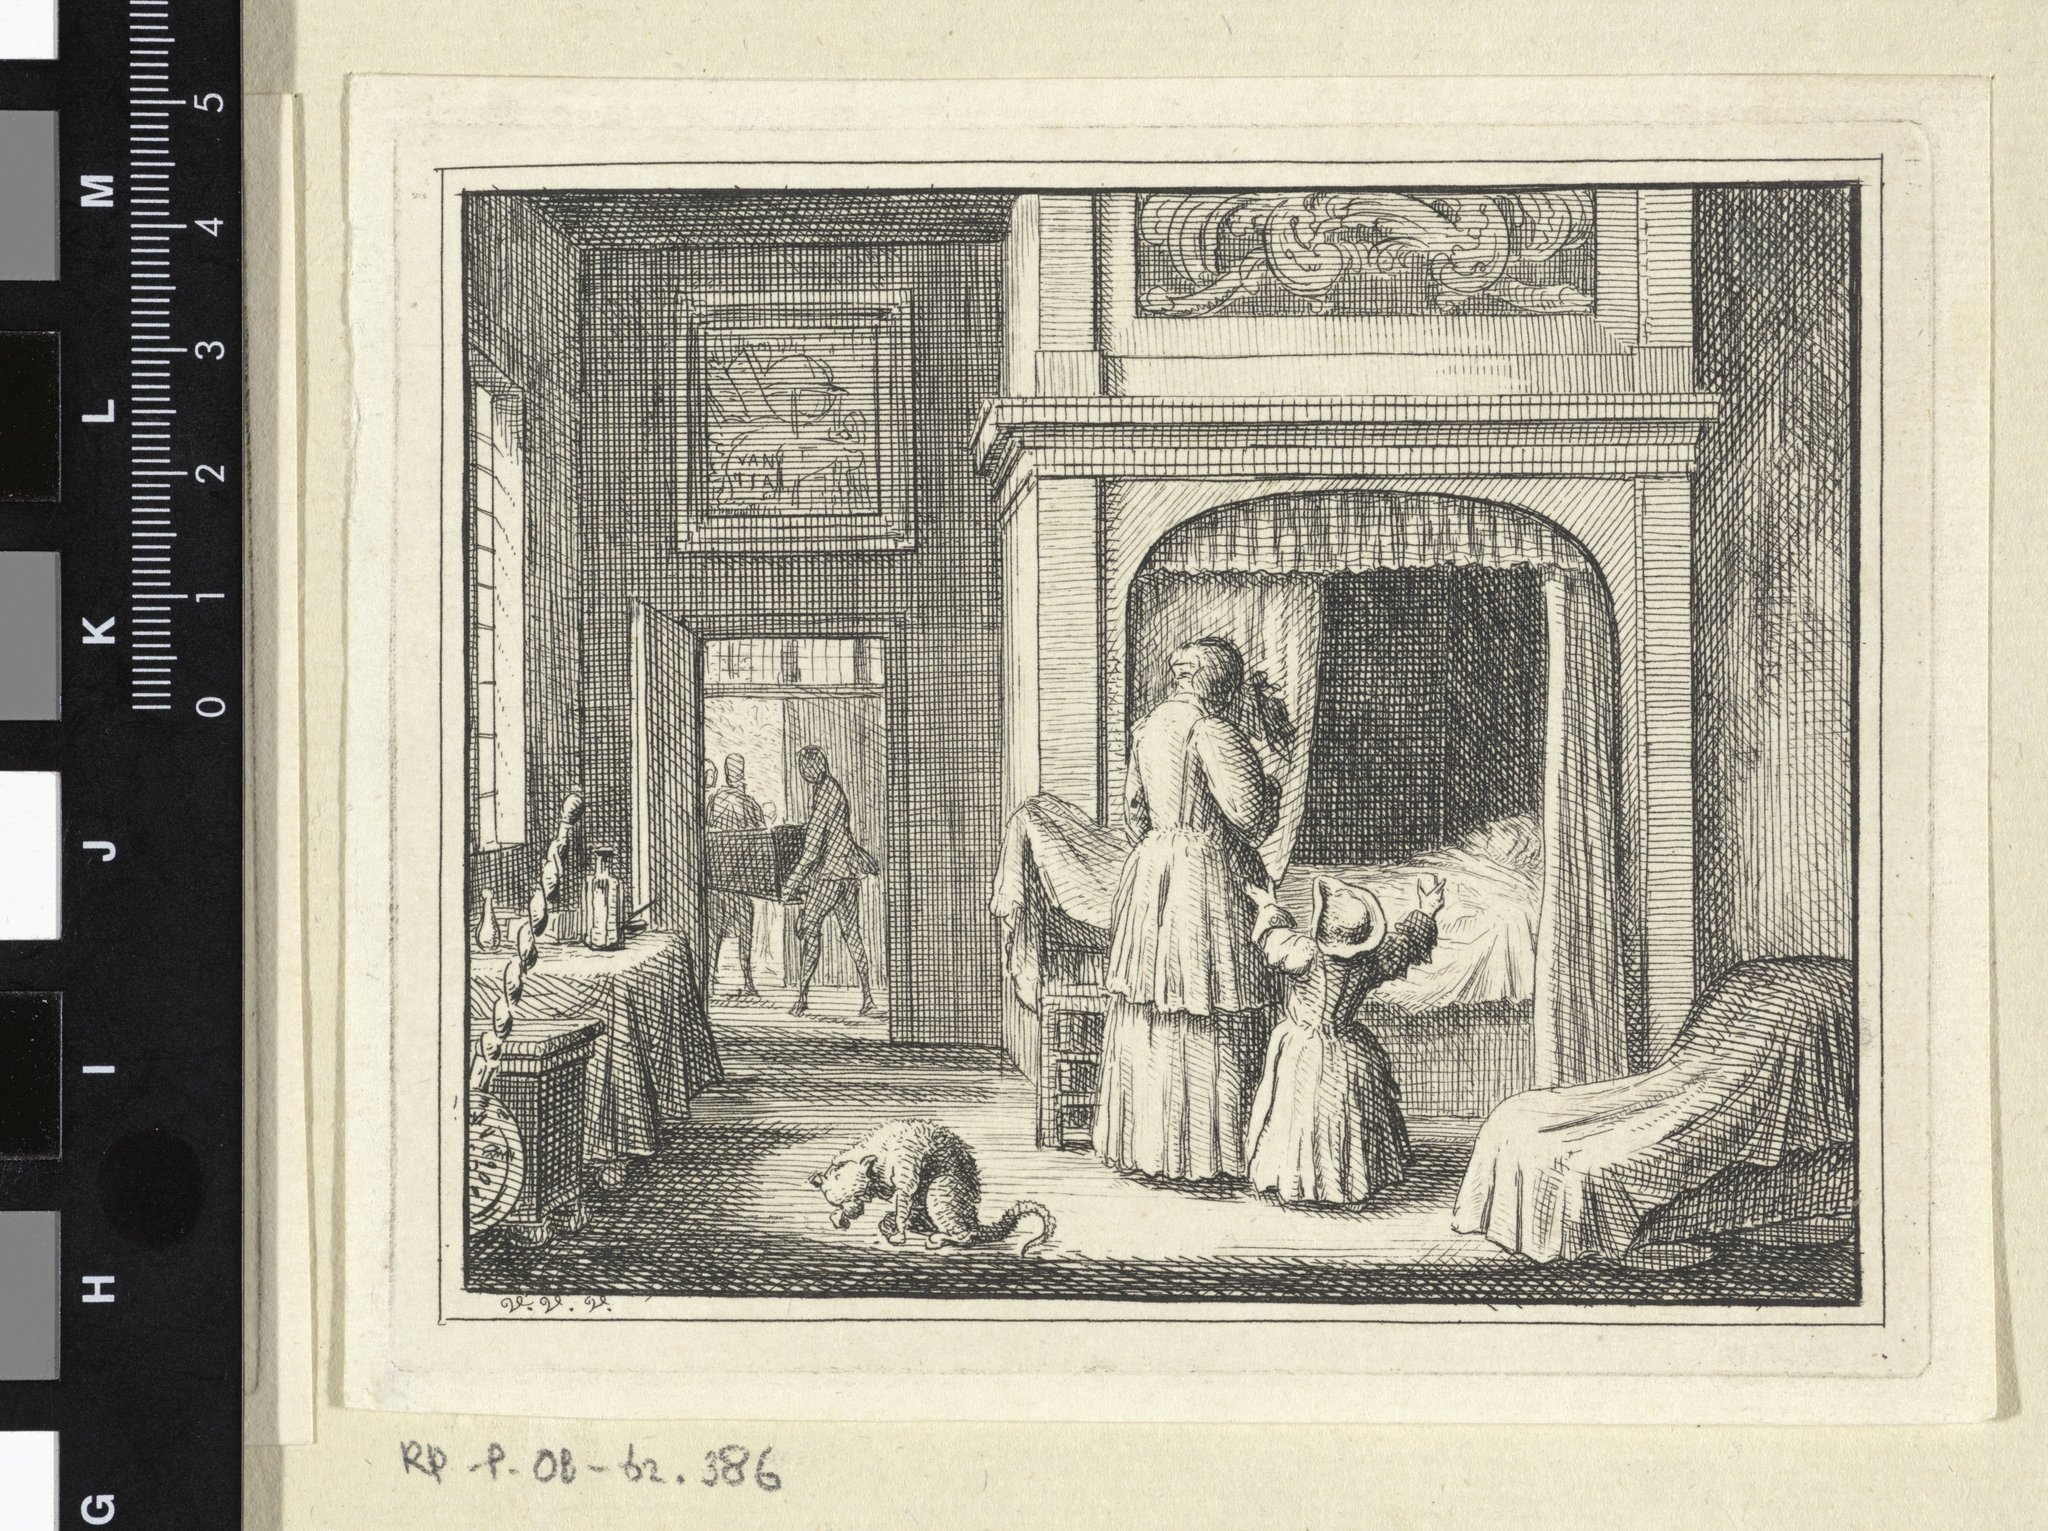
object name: print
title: Overleden man op zijn doodsbed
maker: vincent laurensz. van der vinne (ii)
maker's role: draughtsman, print maker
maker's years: 1686-1742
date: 1714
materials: paper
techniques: etching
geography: haarlem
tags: deathbed, coffin, weeping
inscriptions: collector's mark: Lugt 240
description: Prent oorspronkelijk bedoeld als boekillustratie voor: Spinniker, Adriaan. Leerzaame zinnebeelden. Haarlem: [boekverkoper] Isaak van der Vinne (I) en Amsterdam: [drukker] Johannes Krelius, 1714. Later gebruikt als boekillustratie in: Spinniker, Adriaan. Vervolg der leerzaame zinnebeelden, : spiegel der boetvaardigheid en genade en eenige Stichtelyke gezangen. Haarlem: Jan Bosch, 1758.